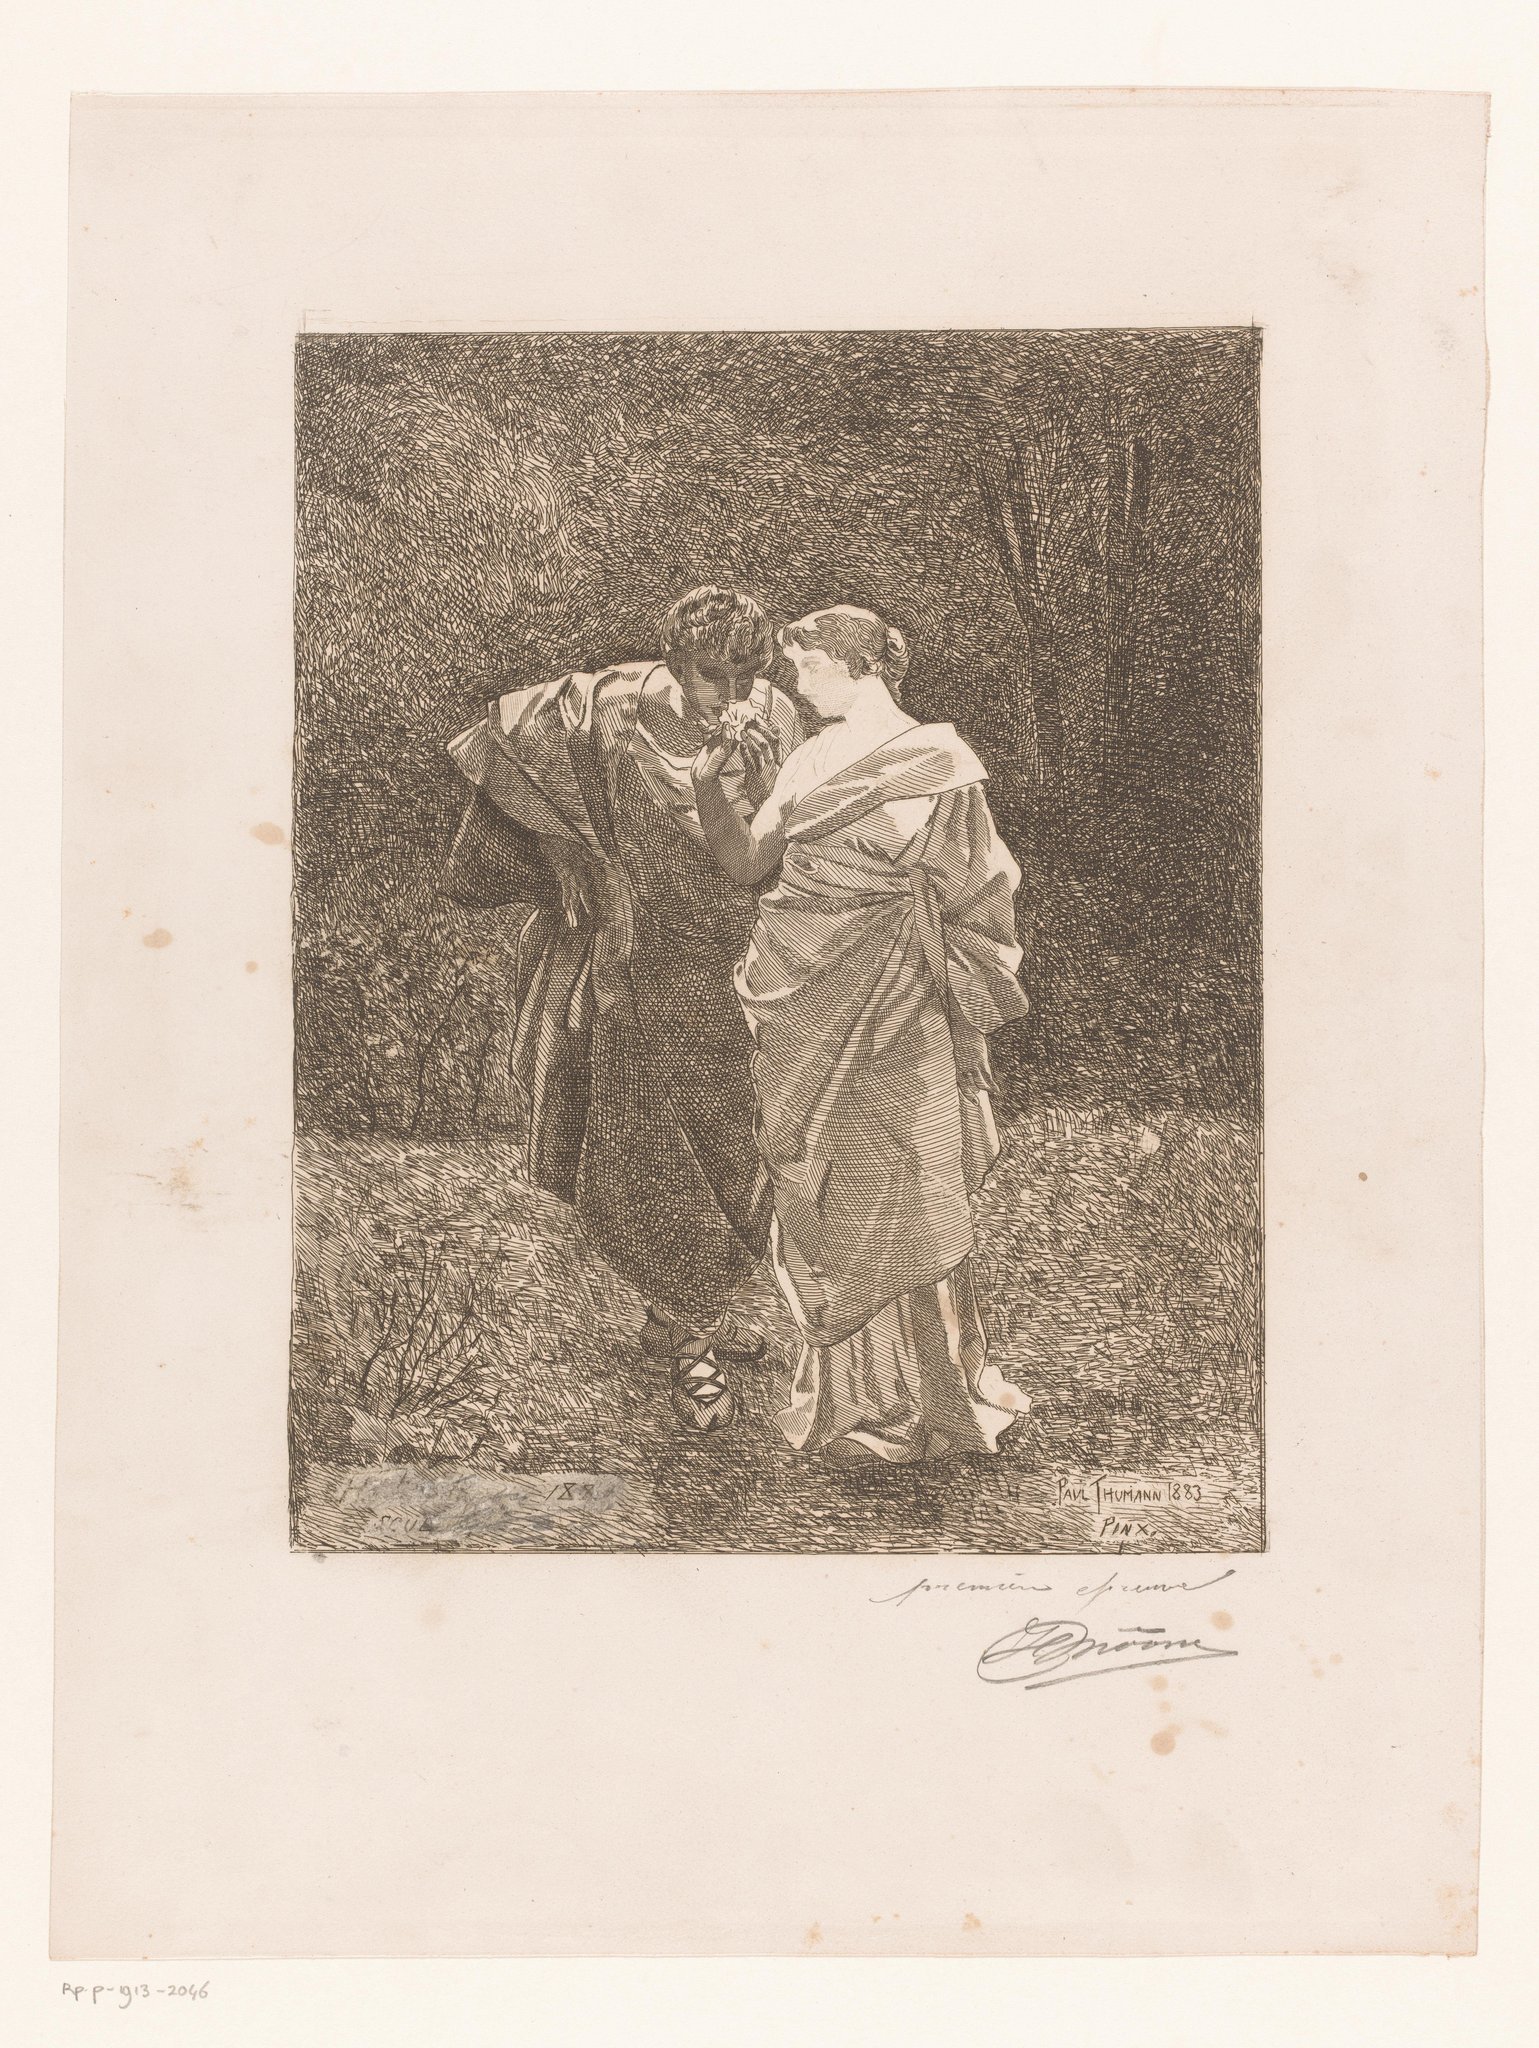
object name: print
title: Jonge man ruikt aan een bloem die een jonge vrouw vasthoudt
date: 1888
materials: paper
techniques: etching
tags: flowers, couple of lovers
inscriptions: inscription: ‘premiere epreuve’, collector's mark: Lugt 2228